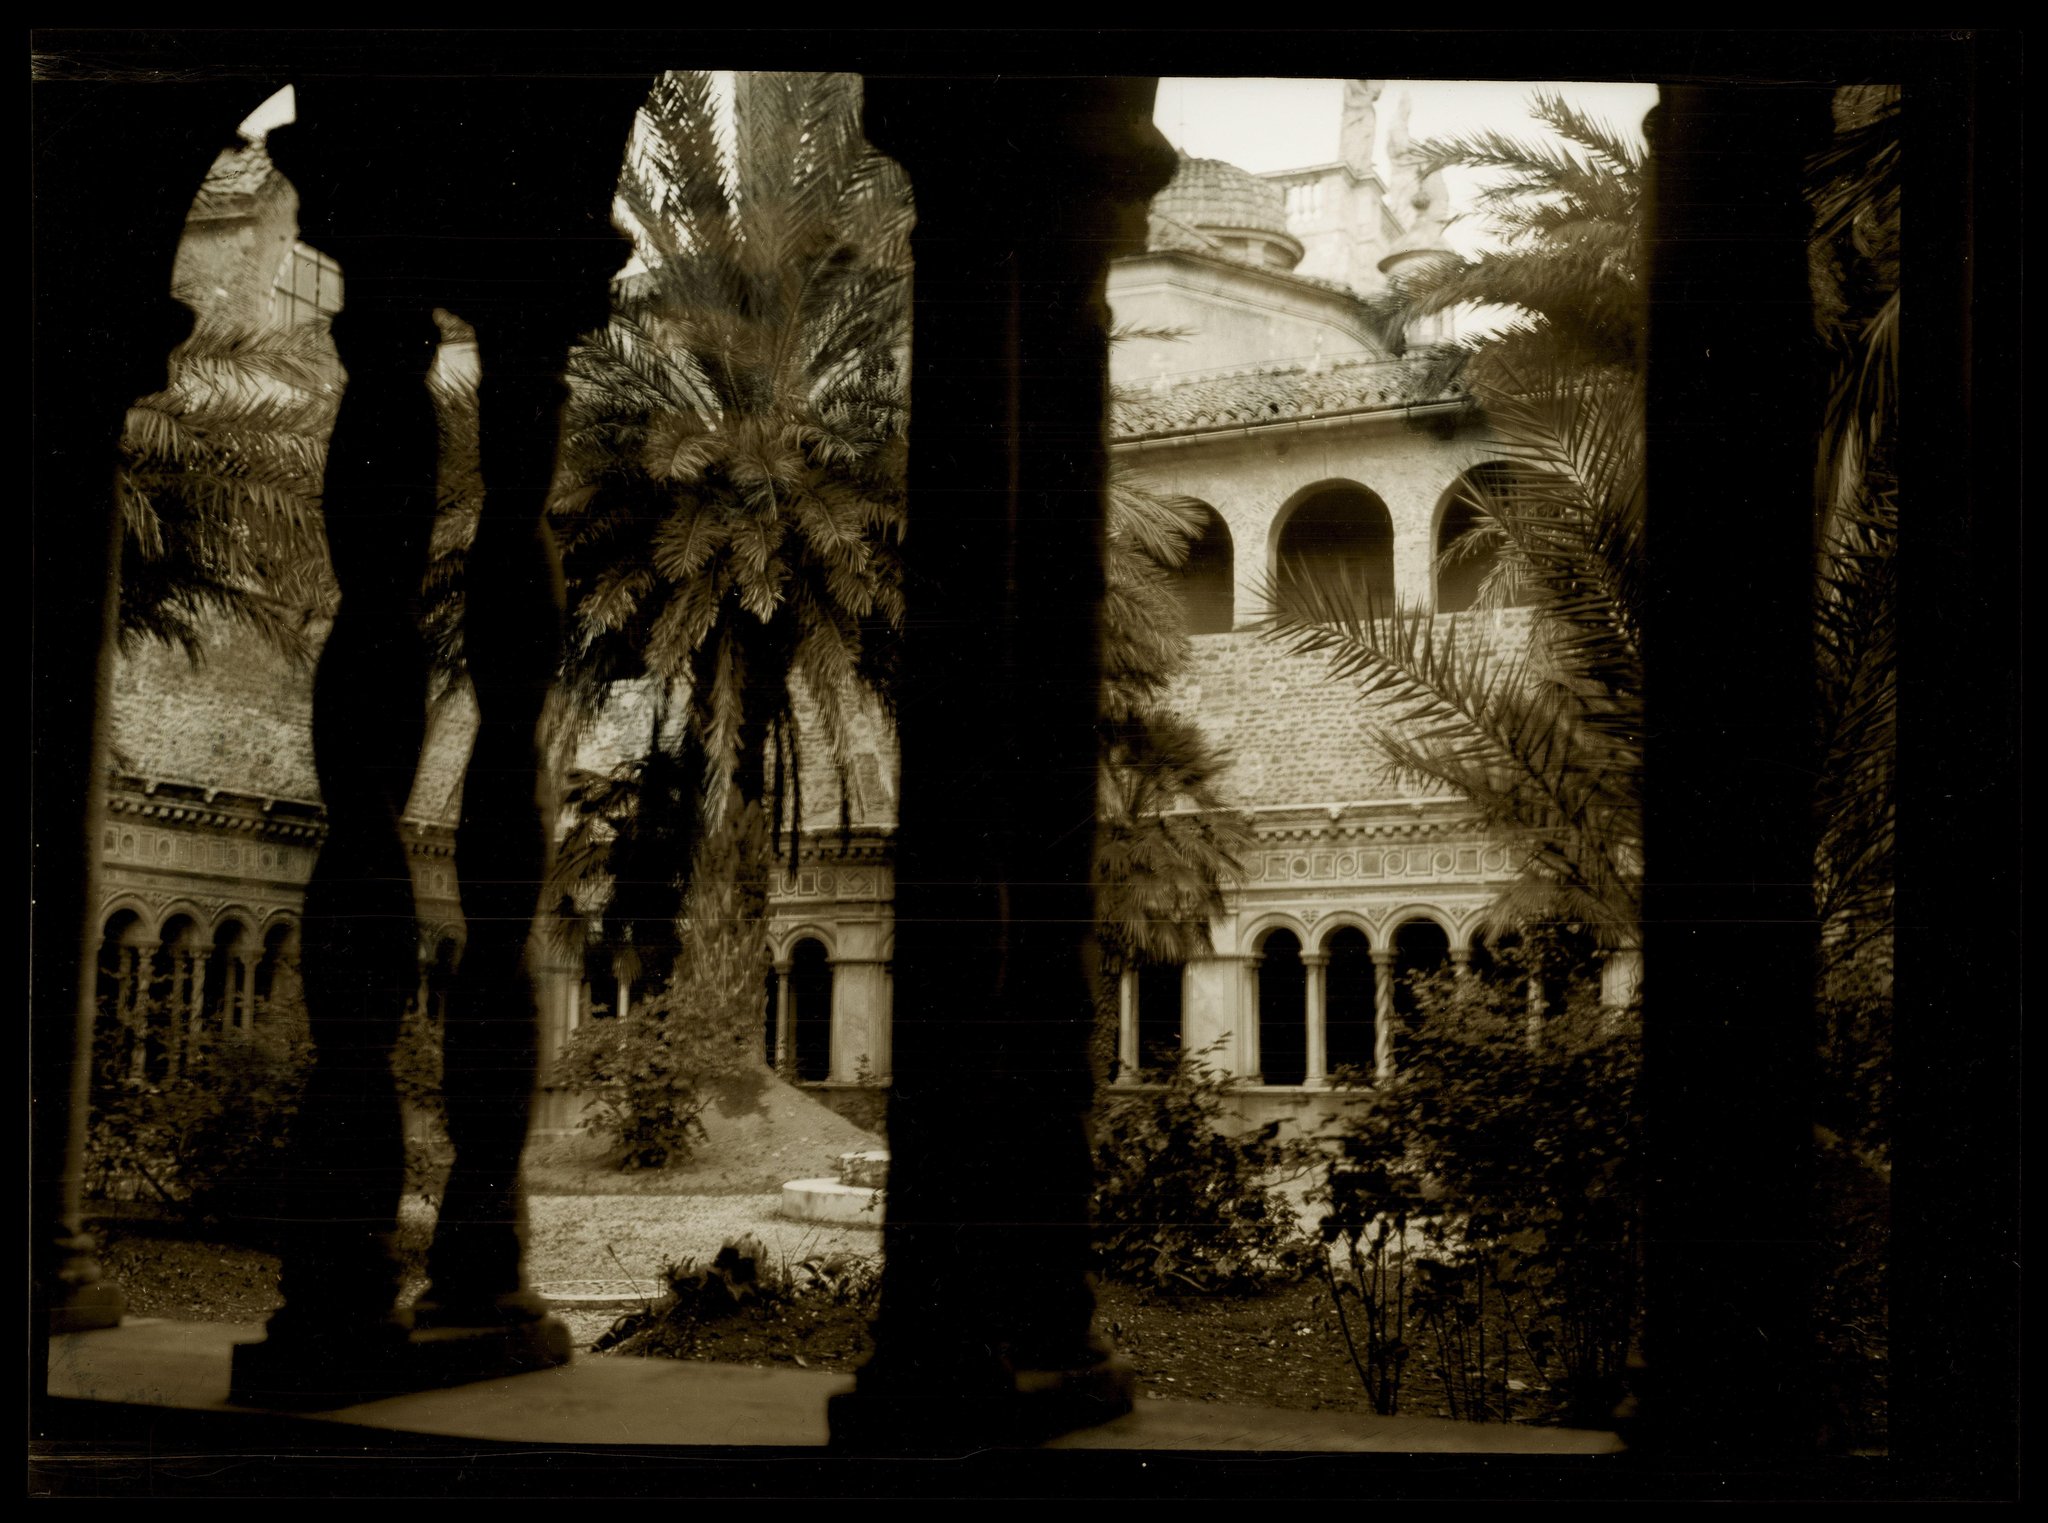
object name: photograph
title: Filmnegatief met opname van Rome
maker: Anonymous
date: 1907-1935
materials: film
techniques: gelatin silver negative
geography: rome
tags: rome